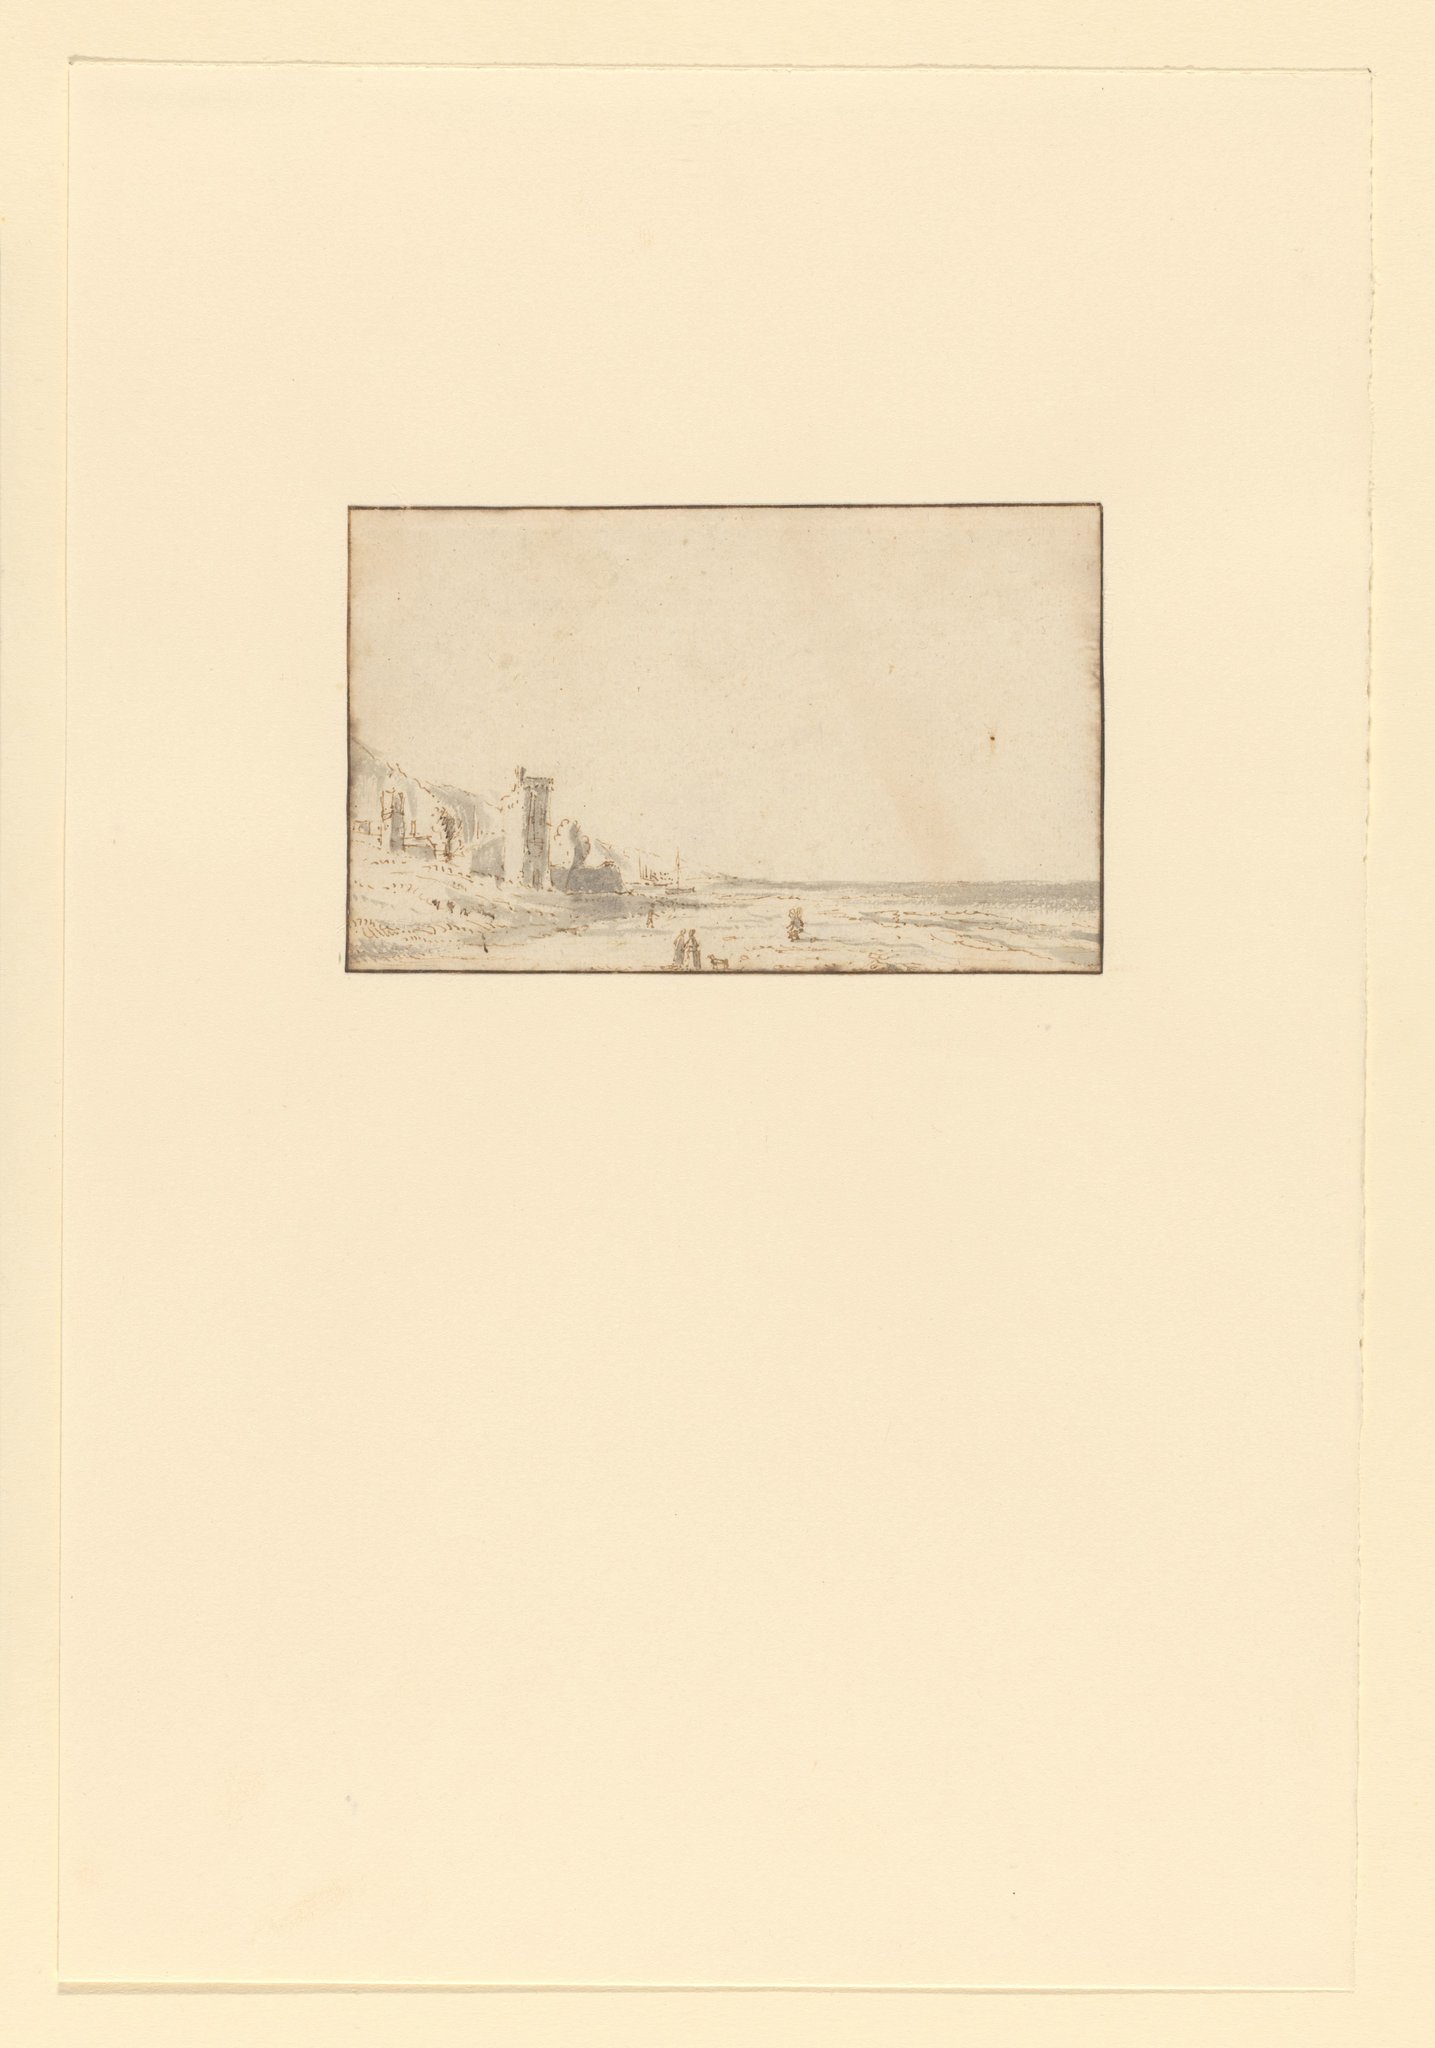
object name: drawing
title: Zeekust met een kasteel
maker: p. kuylaert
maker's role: draughtsman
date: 1600-1699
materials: ink, paper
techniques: brush, pen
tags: castle, beach